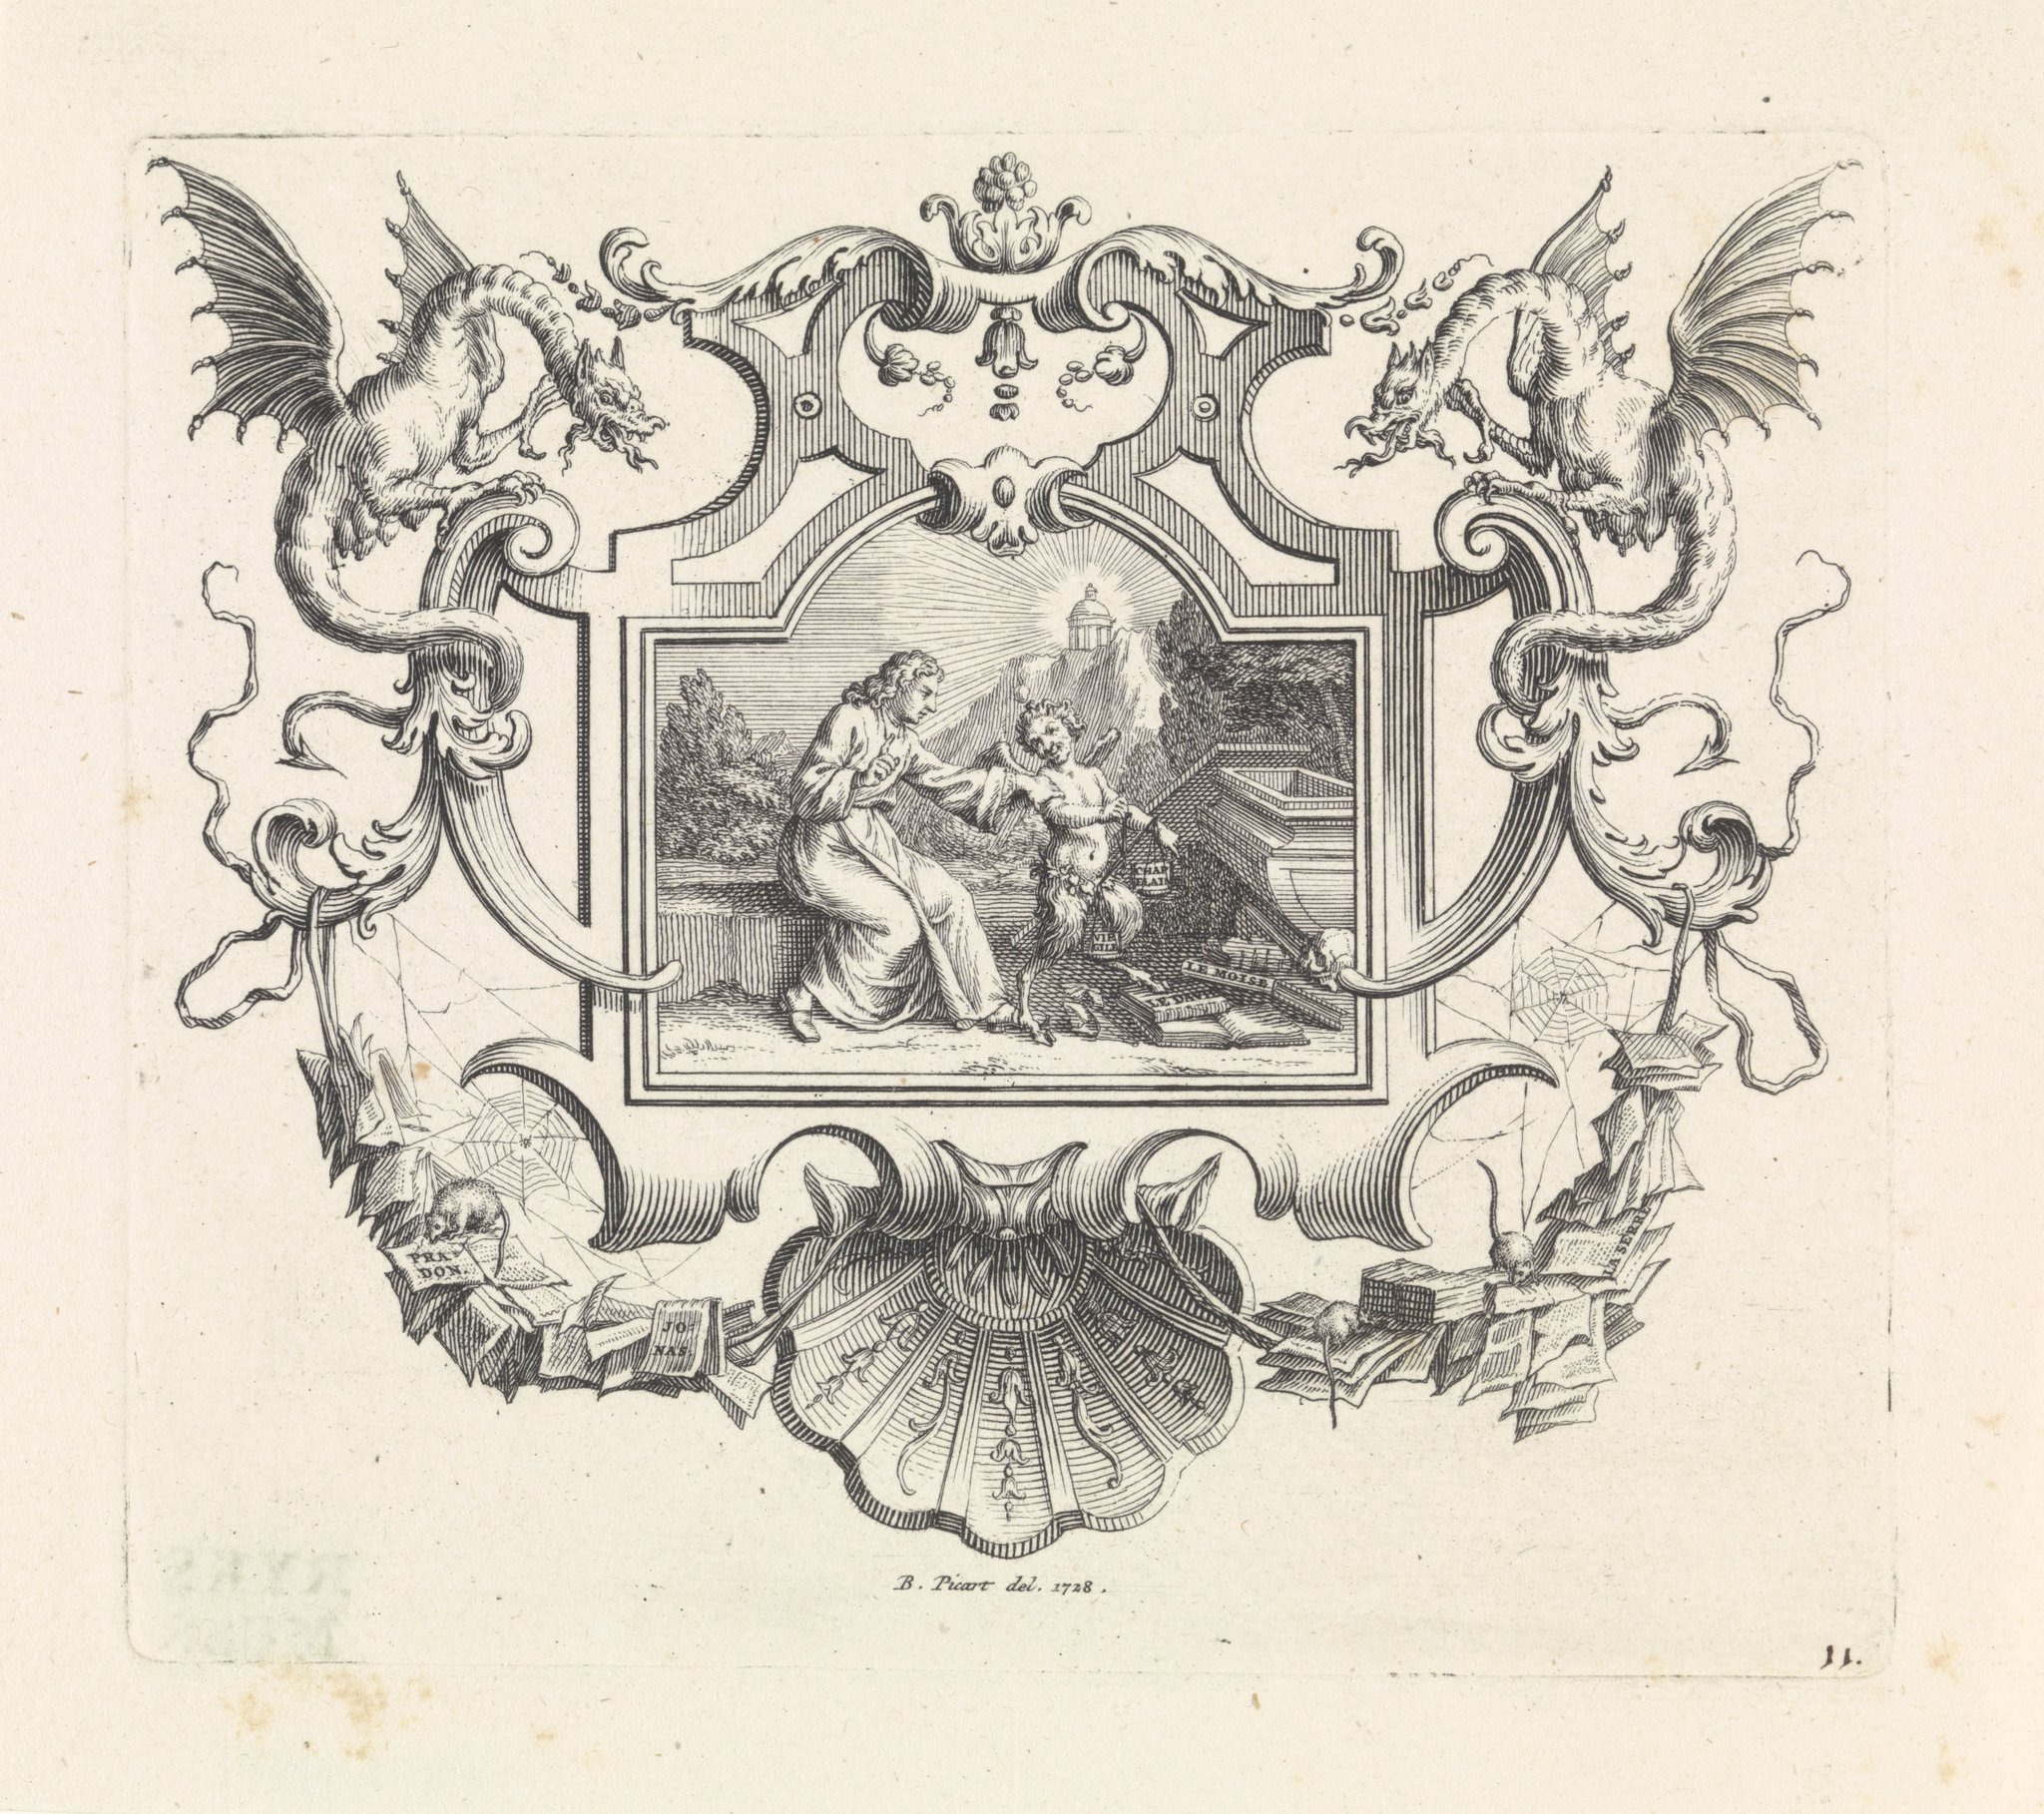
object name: ornament print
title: Nicolas Boileau met een sater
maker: bernard picart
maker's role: draughtsman, print maker, publisher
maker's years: 1673-1733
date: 1728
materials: paper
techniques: engraving, etching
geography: amsterdam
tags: paris, nicolas boileau, ornaments ~ art, parnassus, sacred to apollo musagetes, satyr(s) (in general)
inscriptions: number: ‘11.’, collector's mark: Lugt 2165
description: De schrijver Nicolas Boileau-Despréaux pakt een sater, die de satire verbeeldt, bij de arm. De sater houdt een weegschaal met de namen van Virgilius en Chapelain vast. Op de achtergrond de berg Parnassus. De voorstelling is gevat in een ornamentele lijst met in de bovenhoeken twee draken.